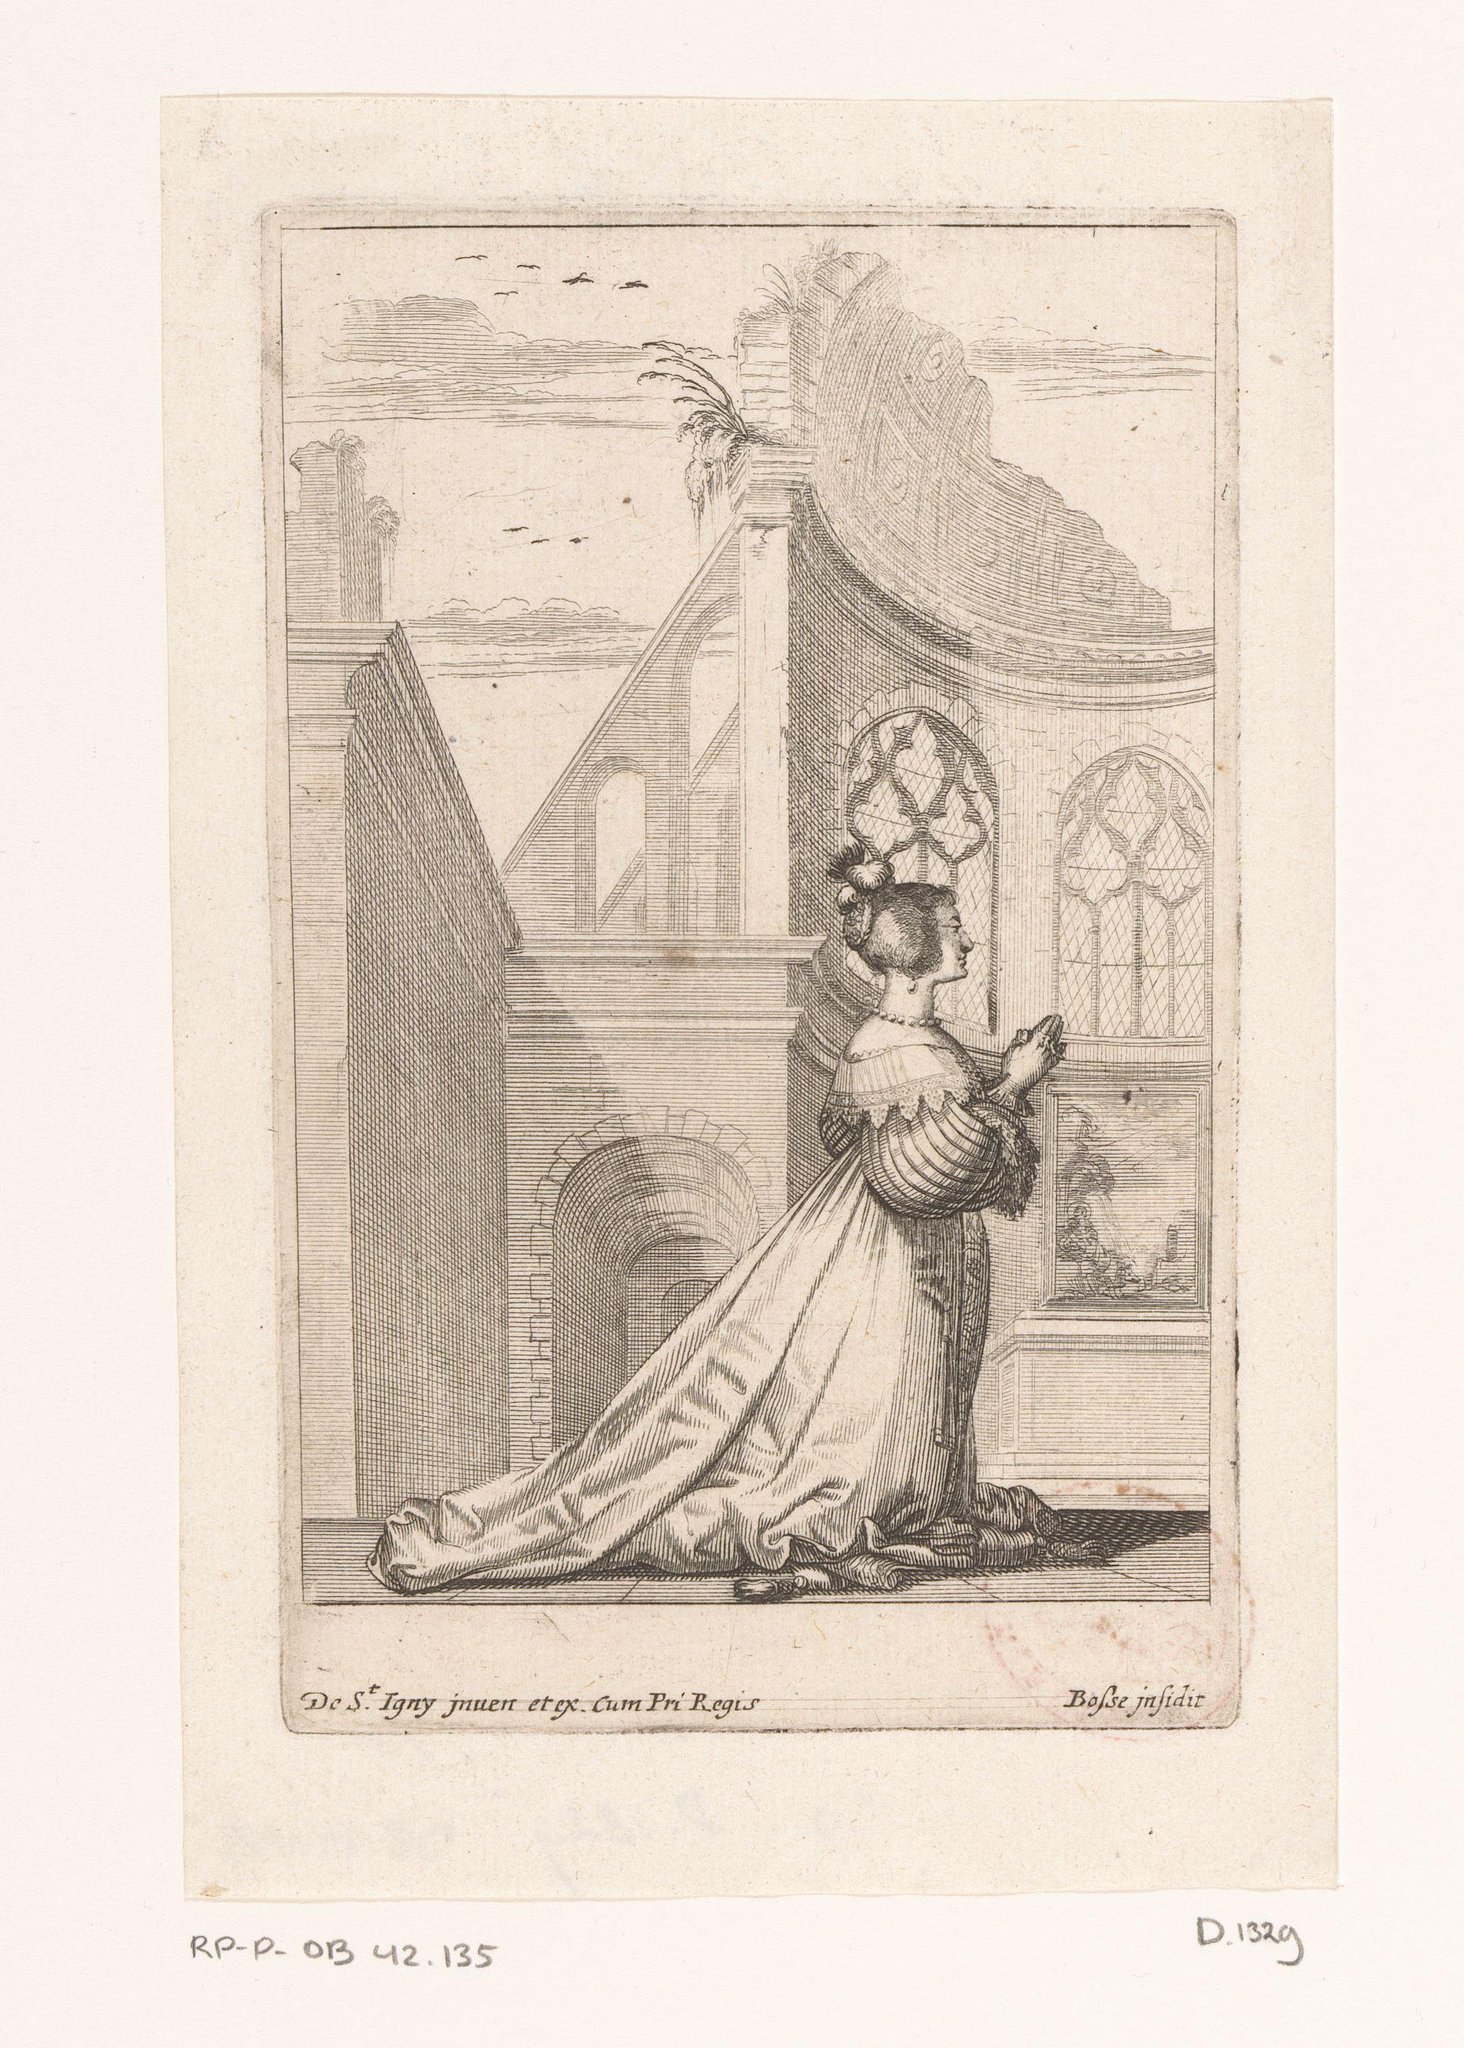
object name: costume print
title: Knielende Franse edelvrouw, gekleed volgens de mode van ca. 1630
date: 1628-1629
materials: paper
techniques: engraving, etching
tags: styles of hairdress - aa - ~ women, neck-gear: collar (+ women's clothes), dress, gown (+ women's clothes), interior of church, sleeves (+ women's clothes), one person praying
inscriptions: collector's mark: Lugt 240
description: Bosse gaf de gotische kerken van Parijs weer als plekken van vroomheid én van mode. De kerkbezoekers op deze prenten dragen de laatste modes tijdens het bidden en flaneren door de kerk. Zo was bijvoorbeeld een dure soort opengewerkte kant populair geworden: reticella. Het werd gebruikt voor uitbundige kragen en manchetten.